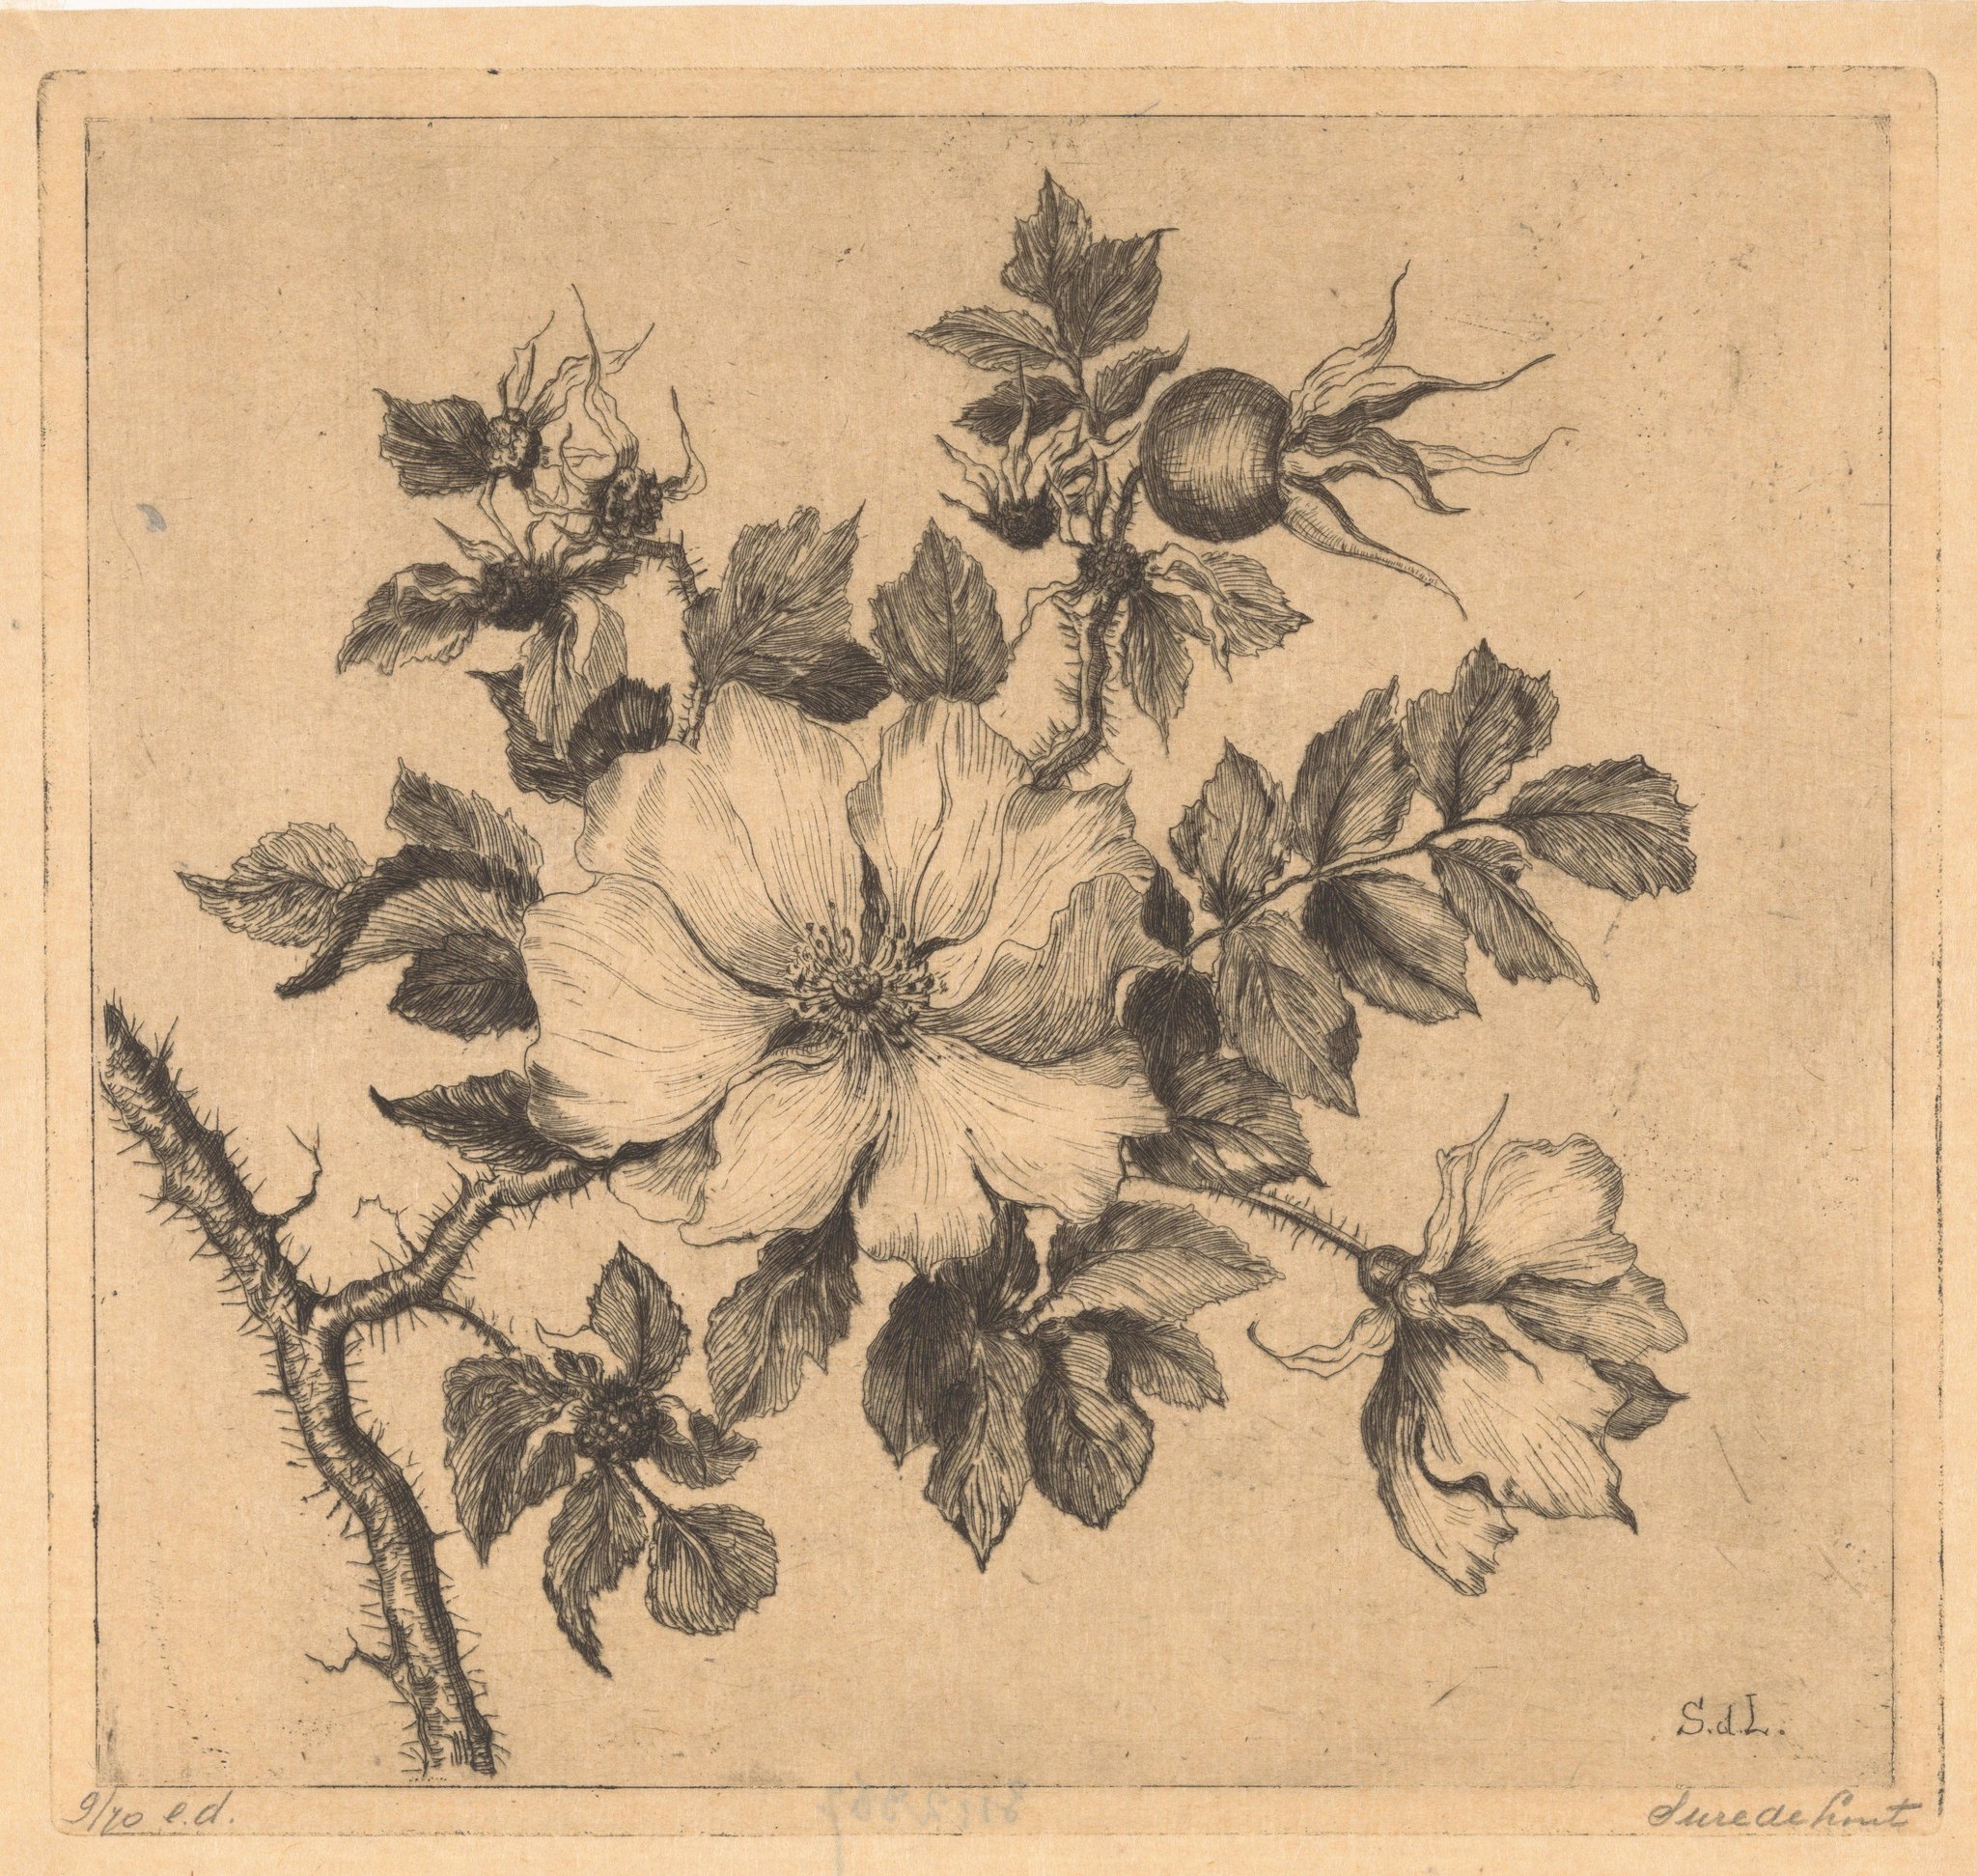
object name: print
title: Rozenbottel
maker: suze de lint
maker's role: print maker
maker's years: 1878-1953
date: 1888-1931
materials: paper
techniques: etching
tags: flowers: rose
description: Een tak met rozenbottels en twee bloeiende rozen.